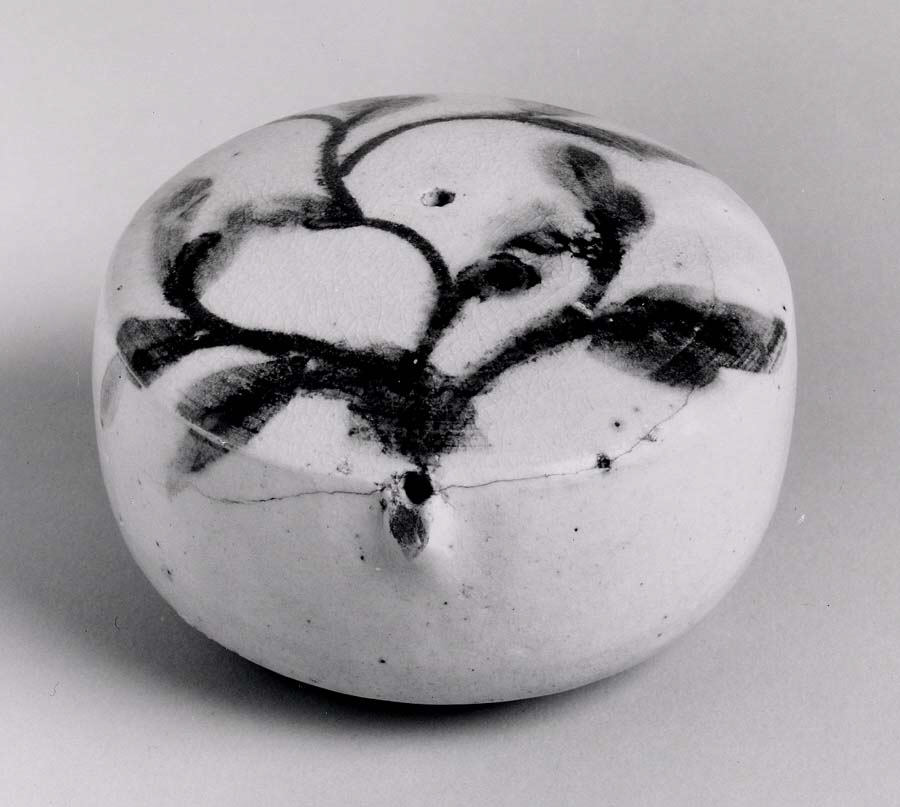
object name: water dropper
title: Water Dropper with a Leaf Spray Design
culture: korean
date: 1901-2000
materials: cobalt, copper, porcelain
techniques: underglaze